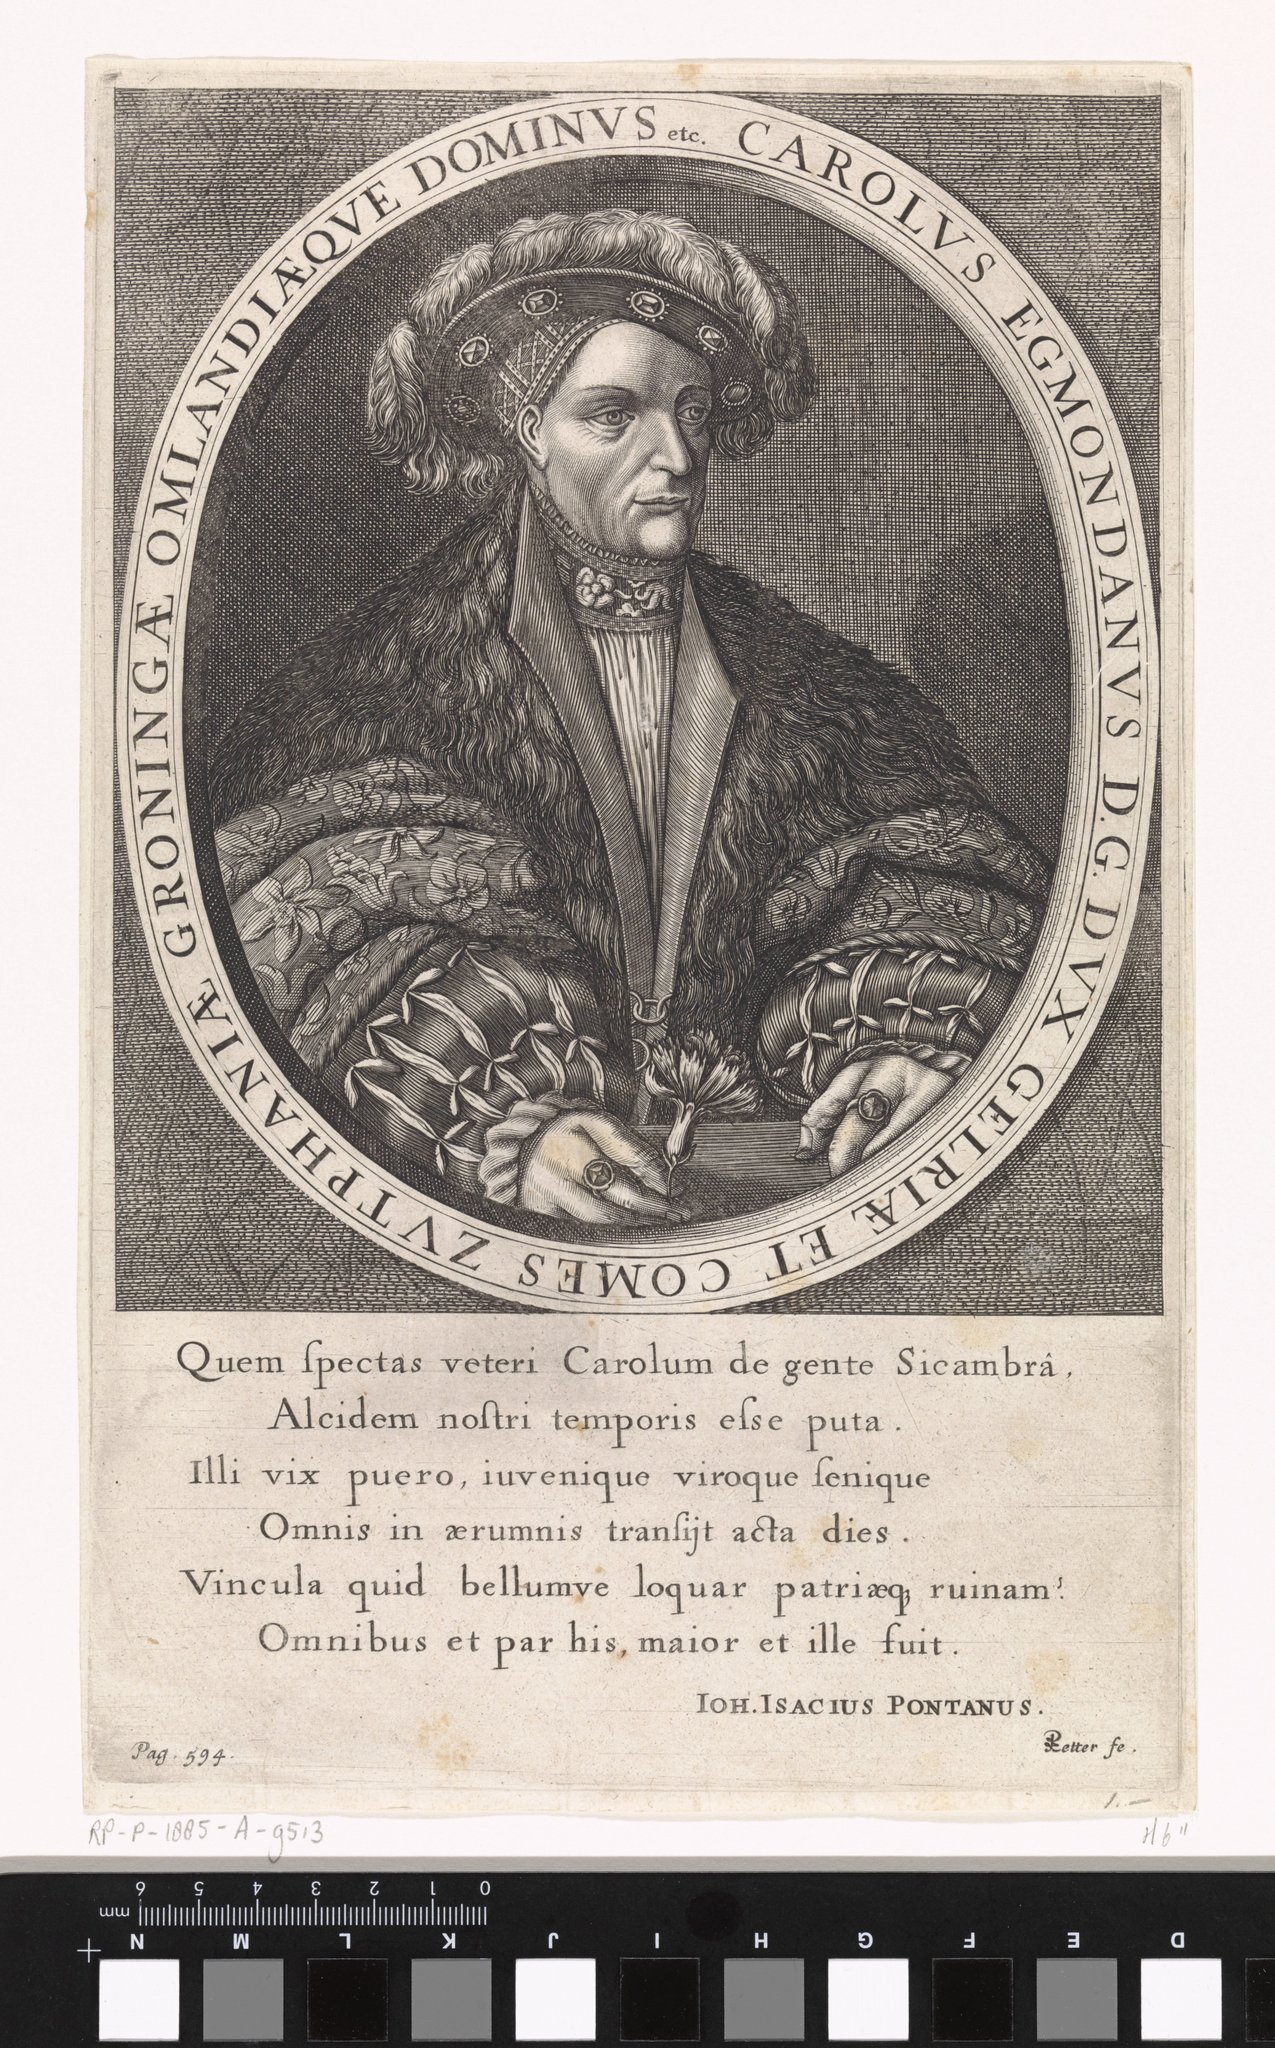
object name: book illustration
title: Portretten van beroemde Europese wetenschappers, humanisten en geestelijken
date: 1639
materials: paper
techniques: engraving, etching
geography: amsterdam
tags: grave, arnhem, earl, karel van egmond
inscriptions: collector's mark: Lugt 2228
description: Portret van Karel van Egmond, hertog van Gelre en graaf van Zutphen, in een ovale lijst. Onderaan een zesregelige tekst in het Latijn. Linksonder: Pag. 594.